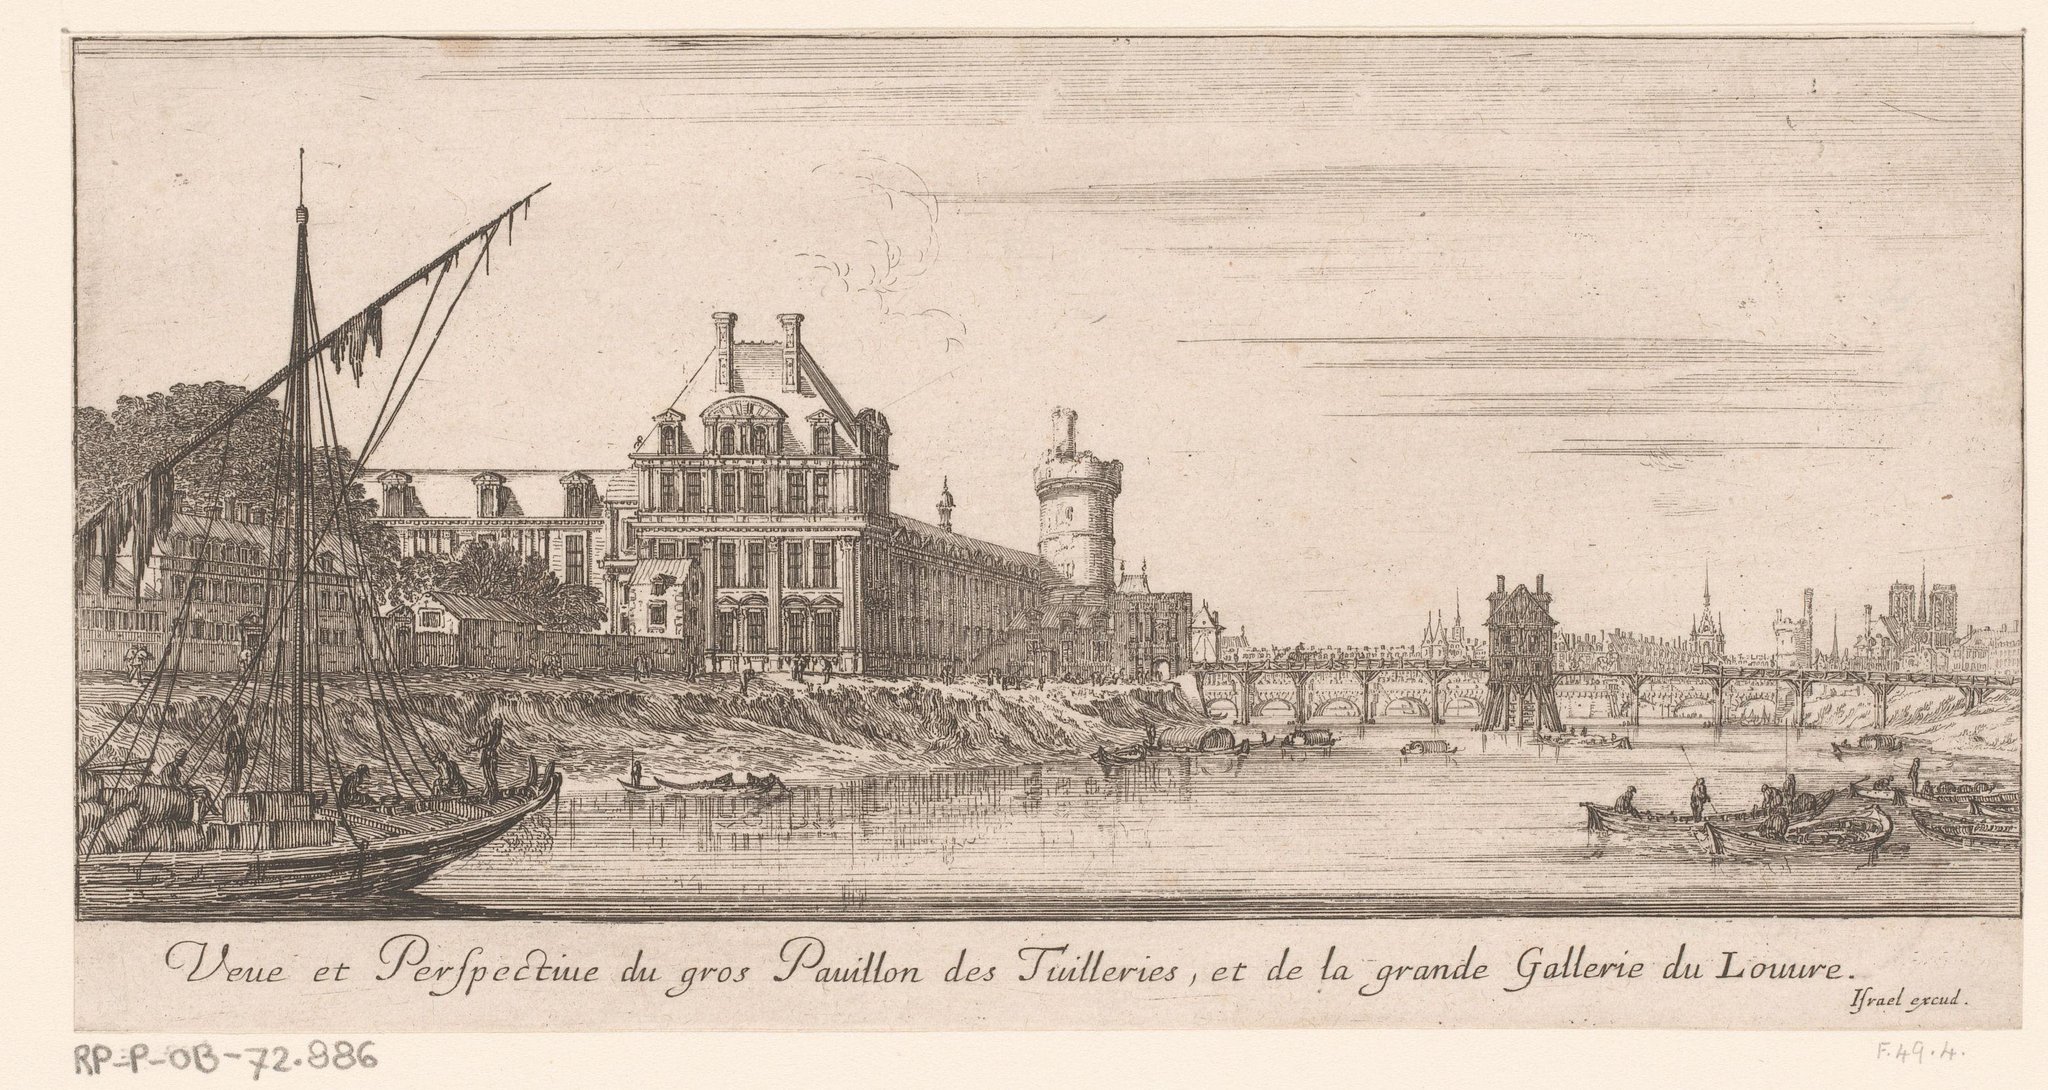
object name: print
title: Veue et Perspective du gros Pavillon des Tuilleries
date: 1650-1655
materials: paper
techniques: engraving, etching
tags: bridge in city across river, canal, etc., paris, tuileries palace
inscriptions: collector's mark: Lugt 240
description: Prent maakt deel uit van een ongenummerde serie van dertien prenten.